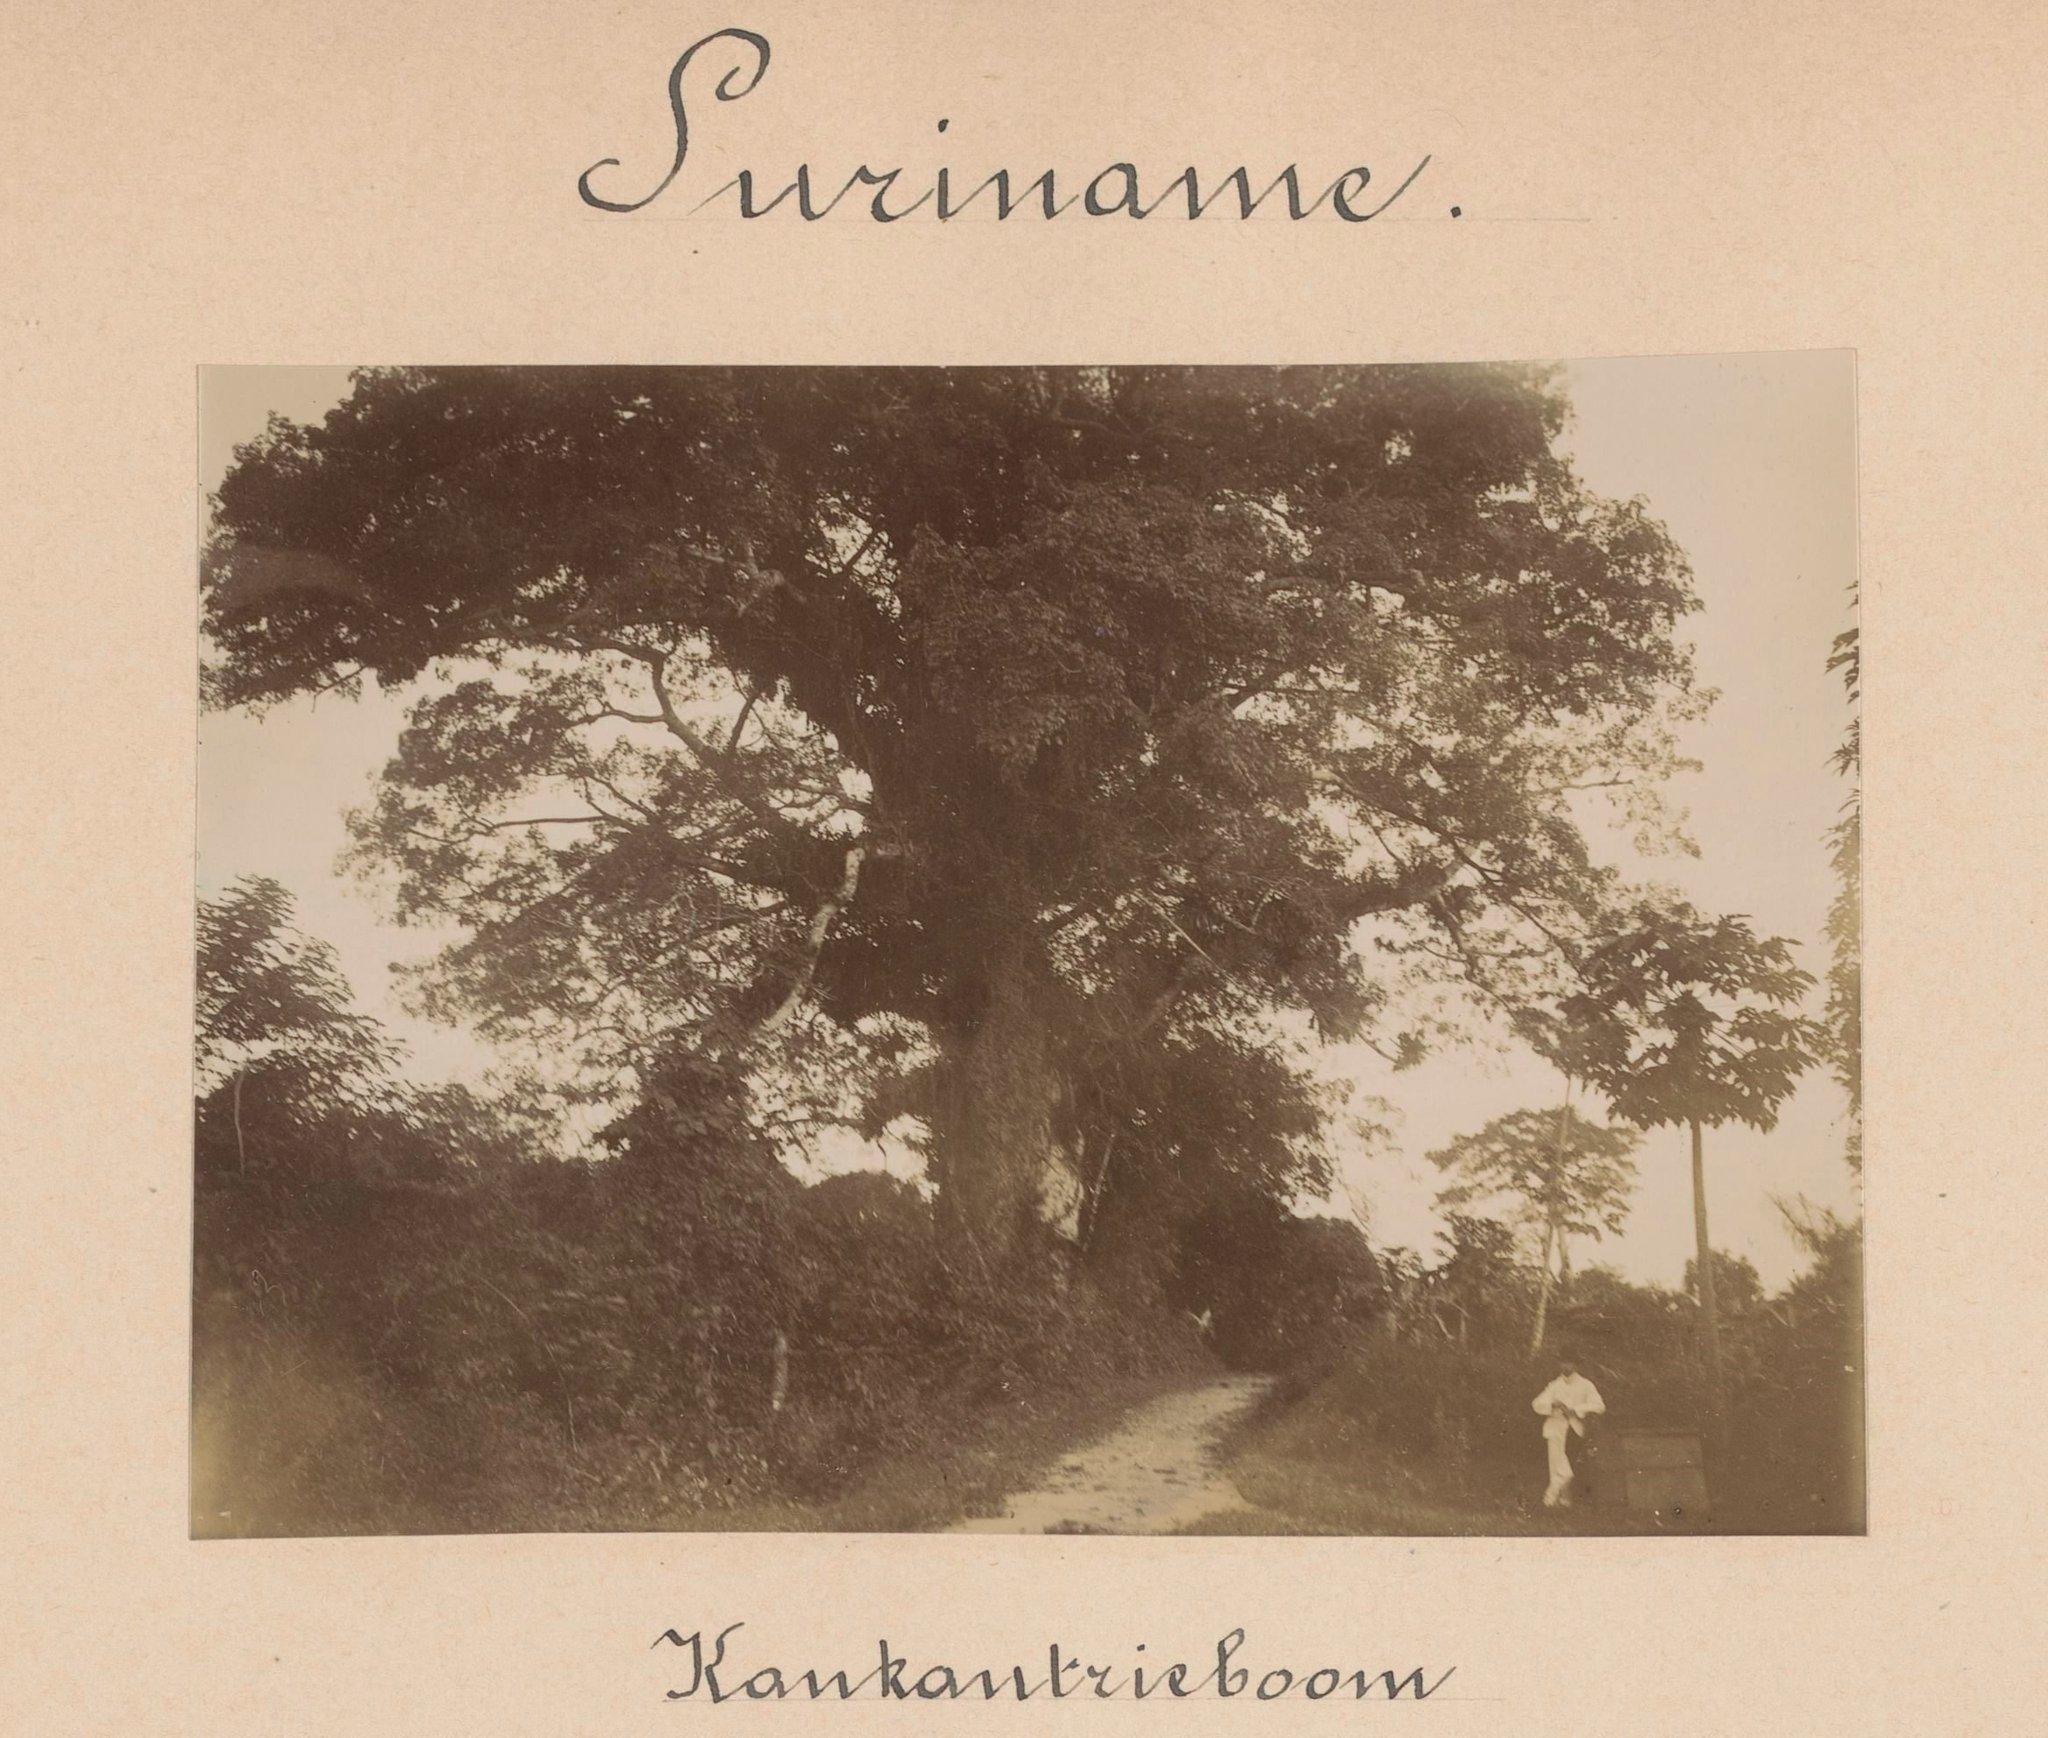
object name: photograph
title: Kankantrieboom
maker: eugen klein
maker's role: fotograaf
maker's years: 1869-1927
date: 1900-1905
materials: cardboard, photographic support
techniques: gelatin silver print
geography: suriname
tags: trees: kapok, suriname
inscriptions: inscription: ‘Suriname / Kankantrieboom’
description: Een grote kankantrie (wilde kapokboom) langs een pad. Rechts staat een man. Fotoafdruk op een blad geplakt samen met twee andere foto's. Onderdeel van een groep van 44 foto's van Paramaribo, Suriname en Curaçao, ca. 1900-1905, opgeplakt op kartons en voorzien van opschriften.